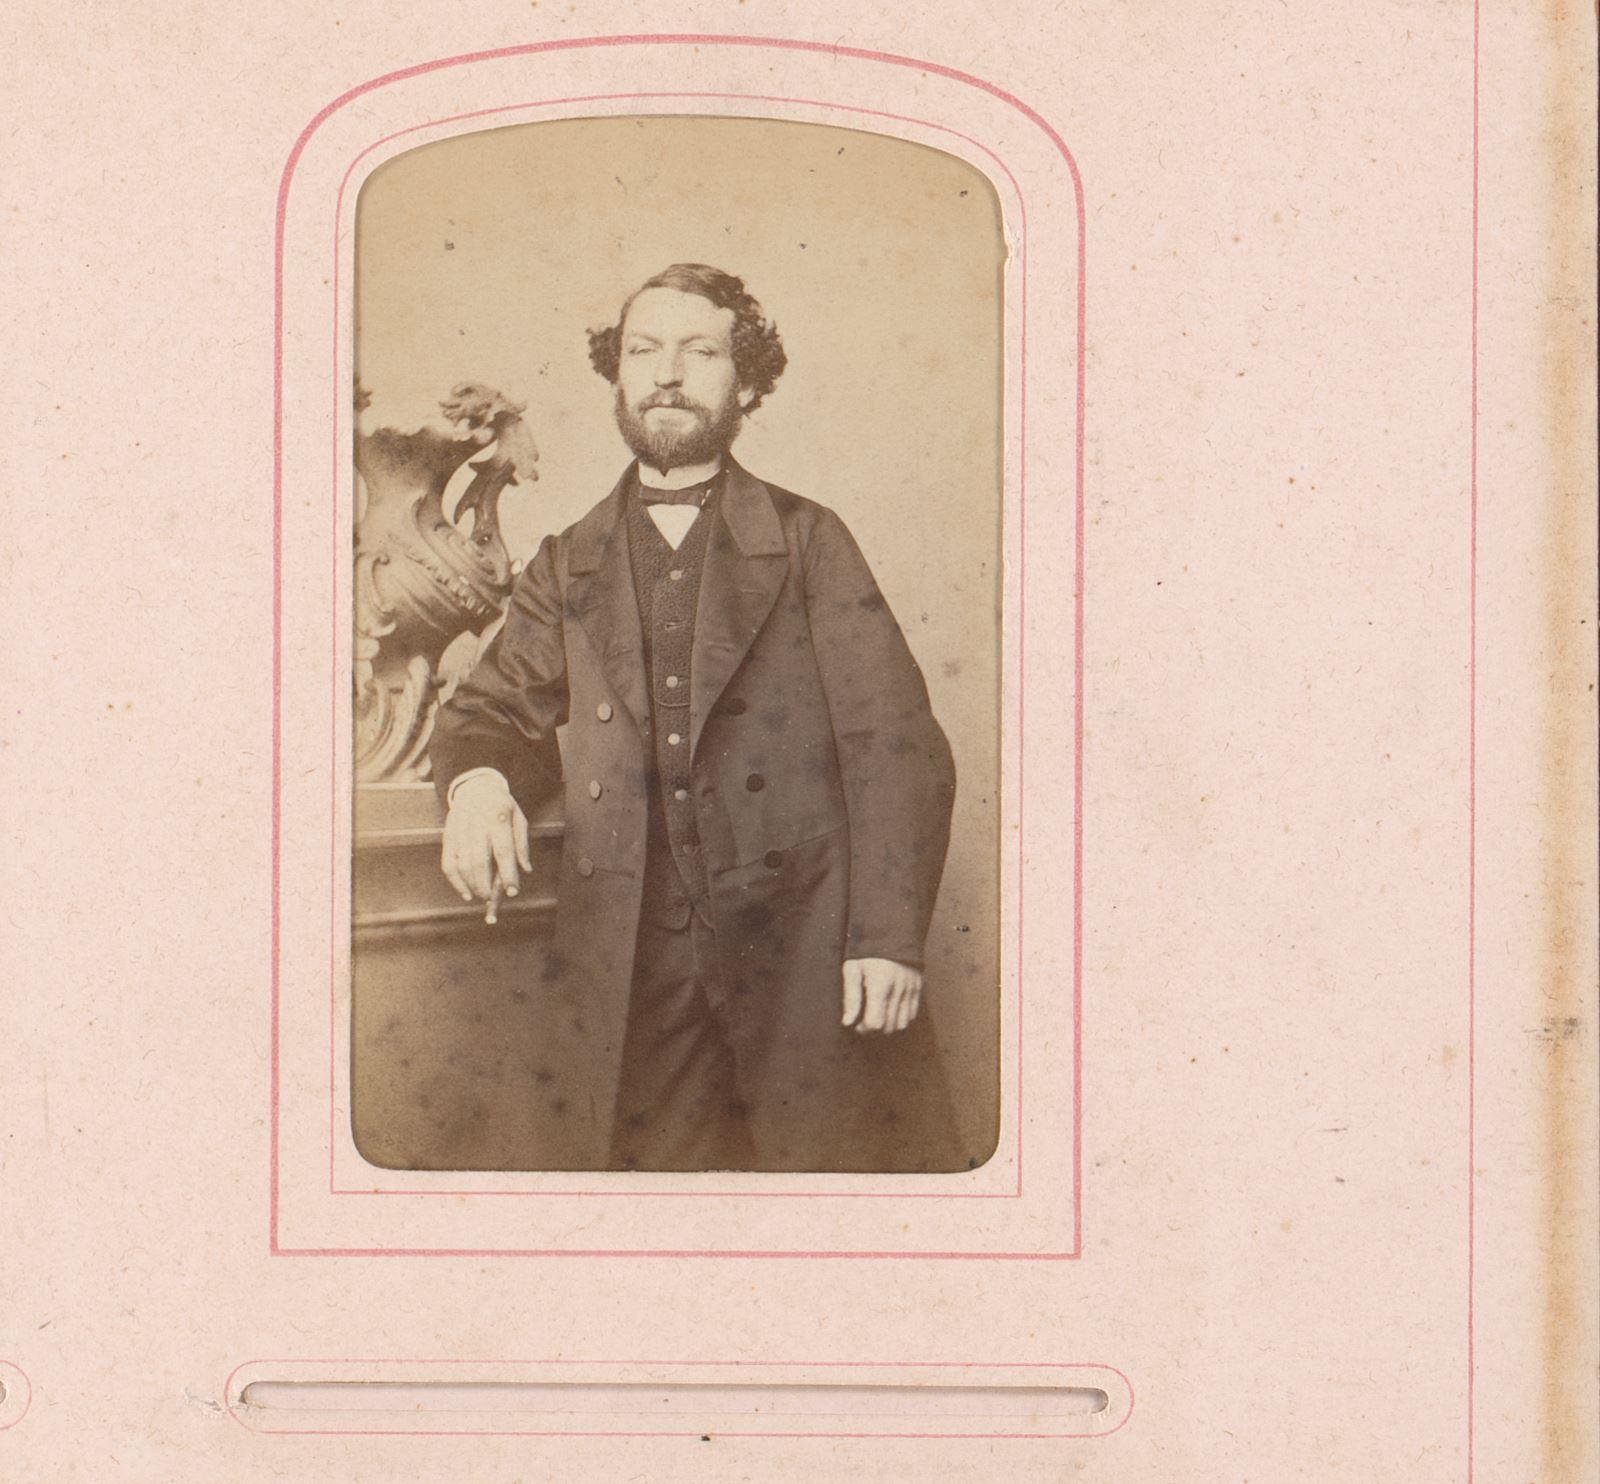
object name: photograph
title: Portret van een man met sigaar leunen tegen piëdestal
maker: christaan marcussen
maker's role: fotograaf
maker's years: 1822-1878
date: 1862-1868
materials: cardboard, paper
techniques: albumen print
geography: amsterdam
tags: cigar, adult man, historical persons, amsterdam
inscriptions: inscription: ‘Engelsch Photographisch Etablissement/ van/ C. Marcussen/ Amsterdam/ Kalverstraat bij de Munt D 39.’